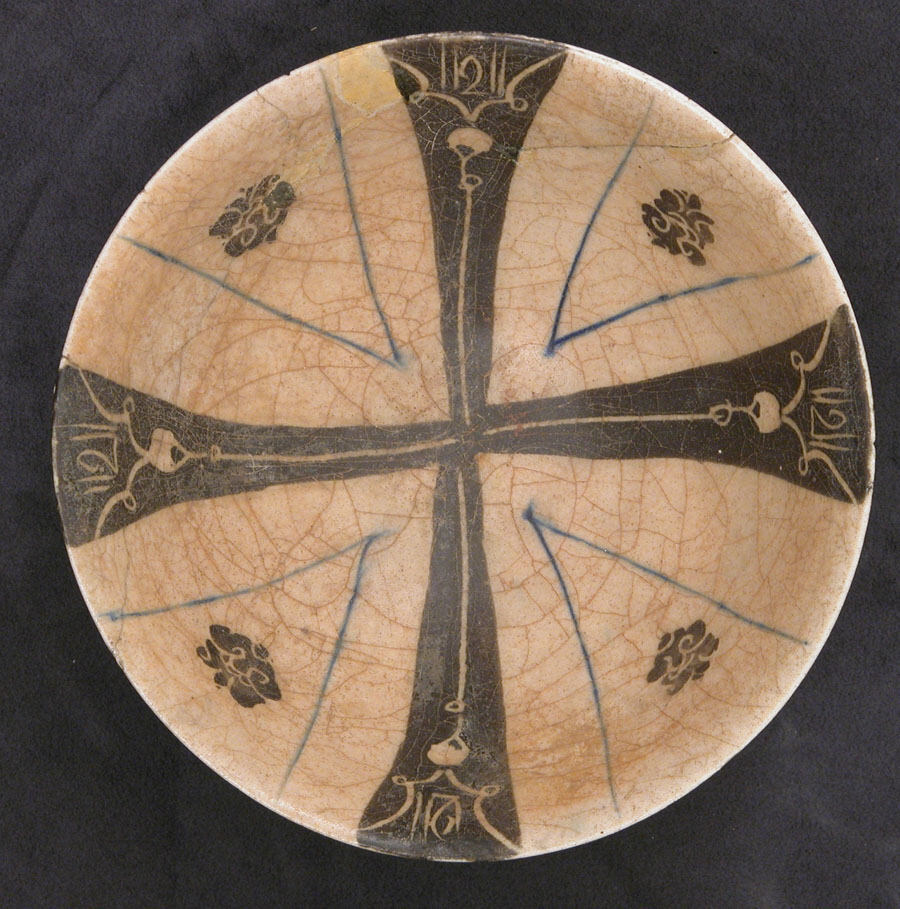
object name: bowl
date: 1101-1200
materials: earthenware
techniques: glazing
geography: iran